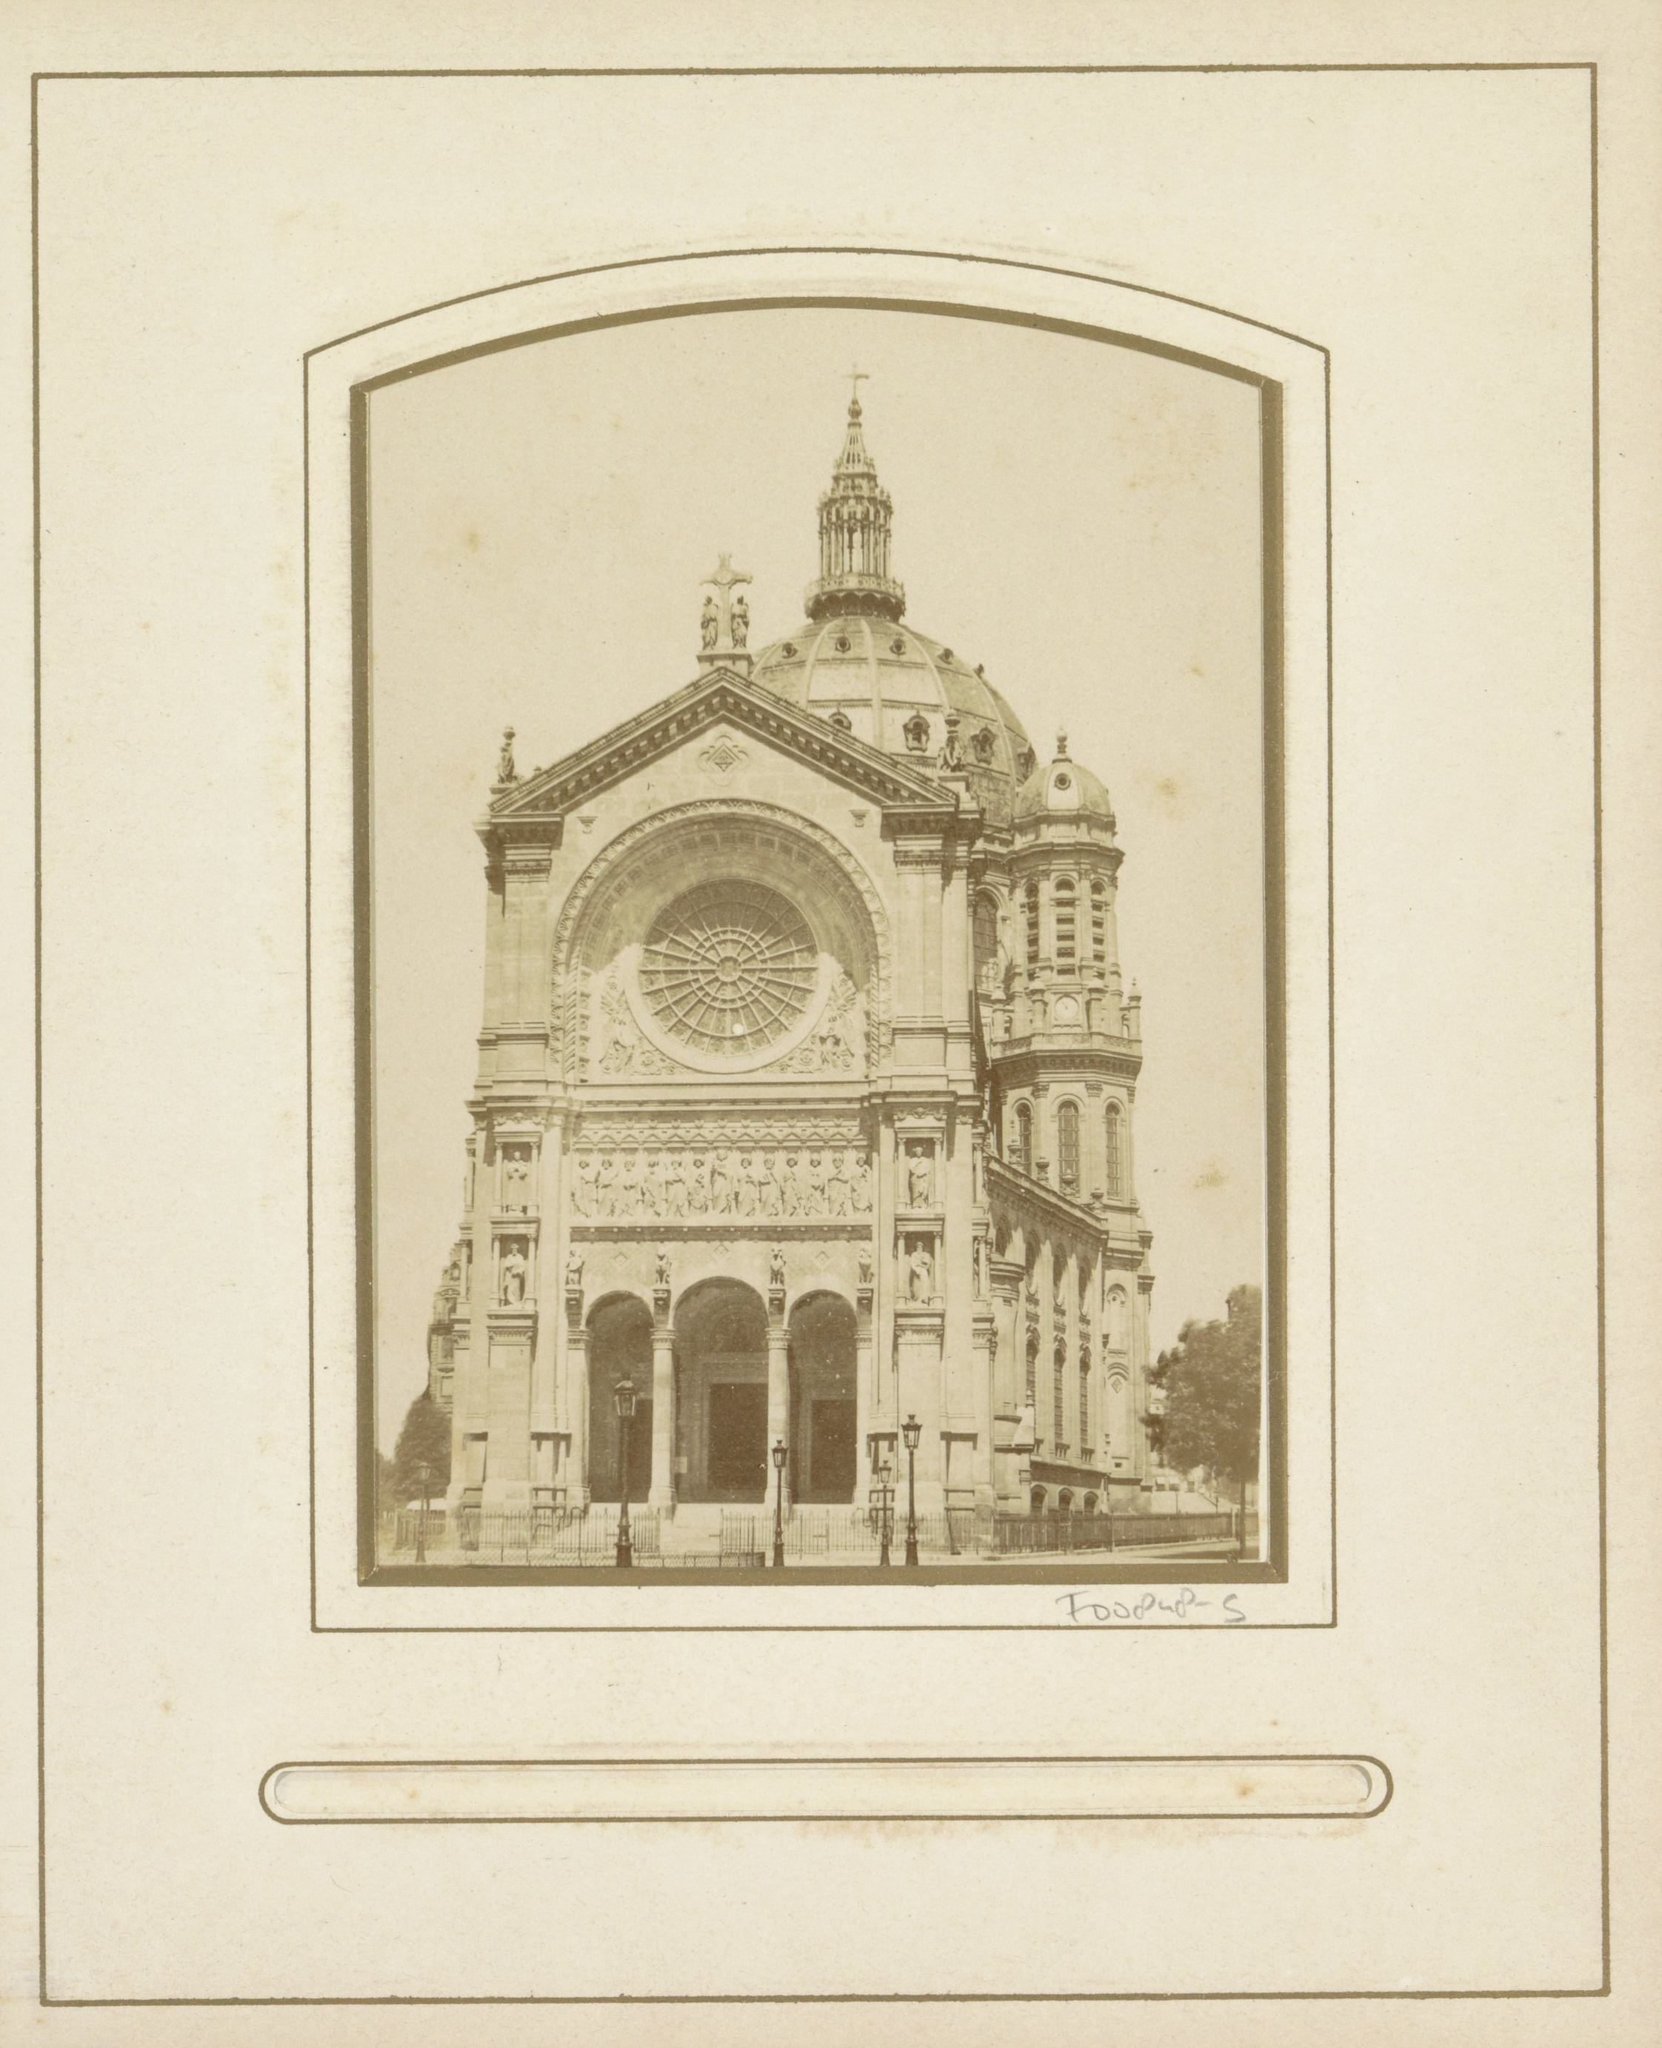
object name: cabinet photograph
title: Exterieur van de Sint-Augustinuskerk in Parijs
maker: Anonymous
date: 1870-1900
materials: cardboard, paper, photographic support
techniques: albumen print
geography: paris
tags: church (exterior), paris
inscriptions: inscription: ‘st augustin’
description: Onderdeel van Fotoalbum met kabinetfoto's van bezienswaardigheden in Parijs en Versailles.